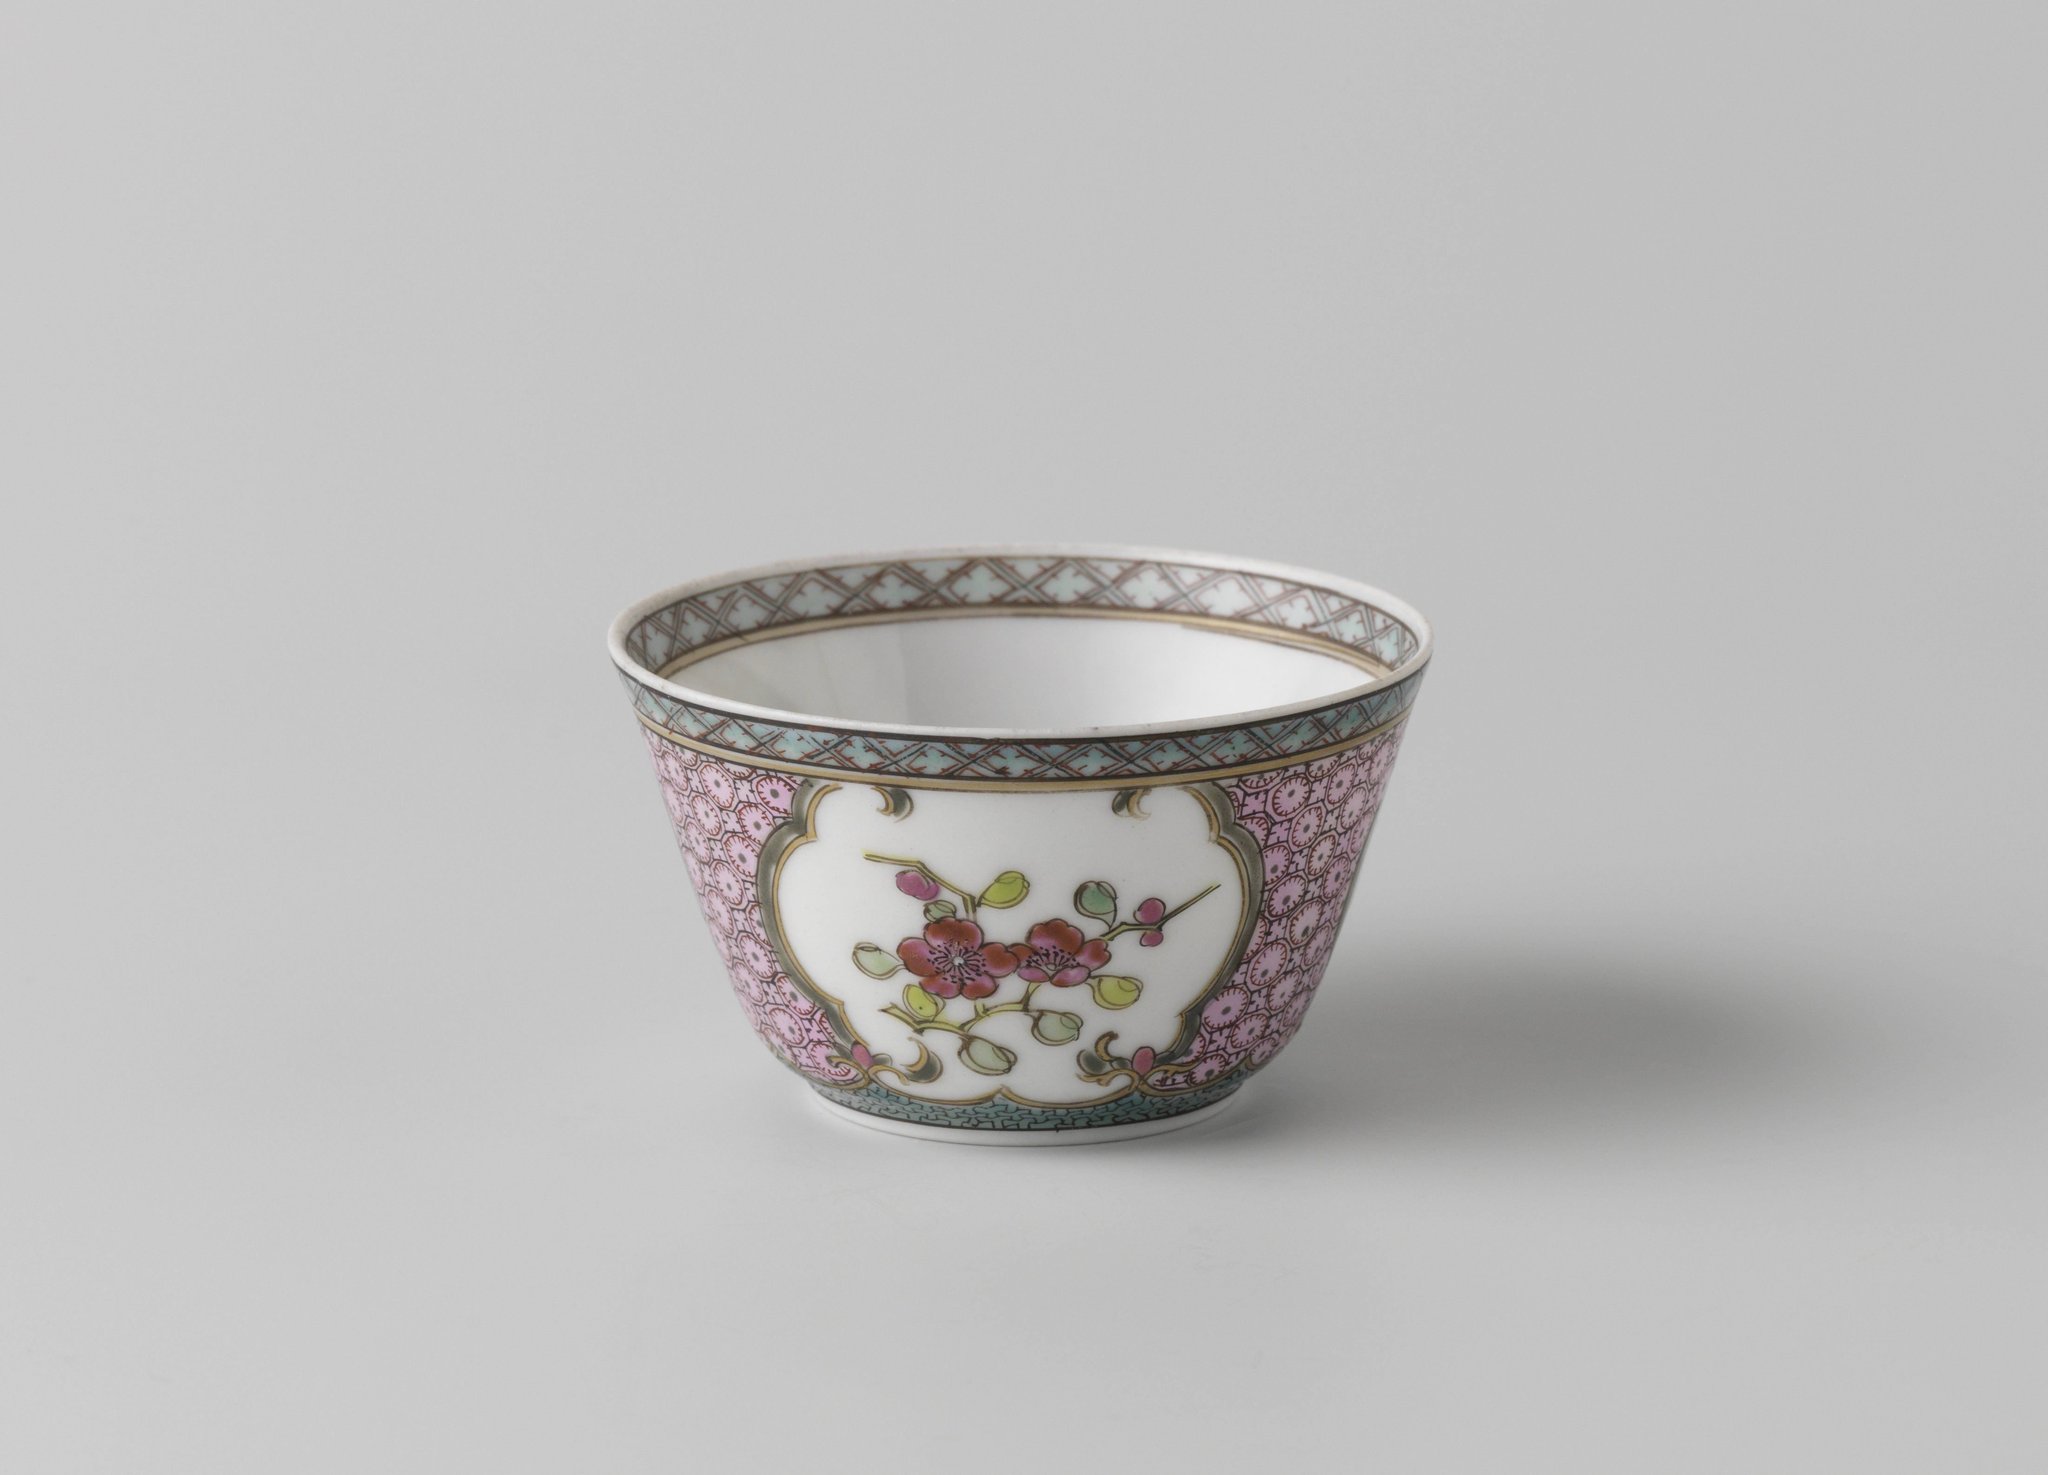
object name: cup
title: Straight-sided cup with flower sprays, vase, fruitbasket and cat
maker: Anonymous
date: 1725-1749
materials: glaze, gold, paint, porcelain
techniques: firing, gilding, turning, vitrification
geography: china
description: Theekom, gedecoreerd in Famille rose-kleuren.